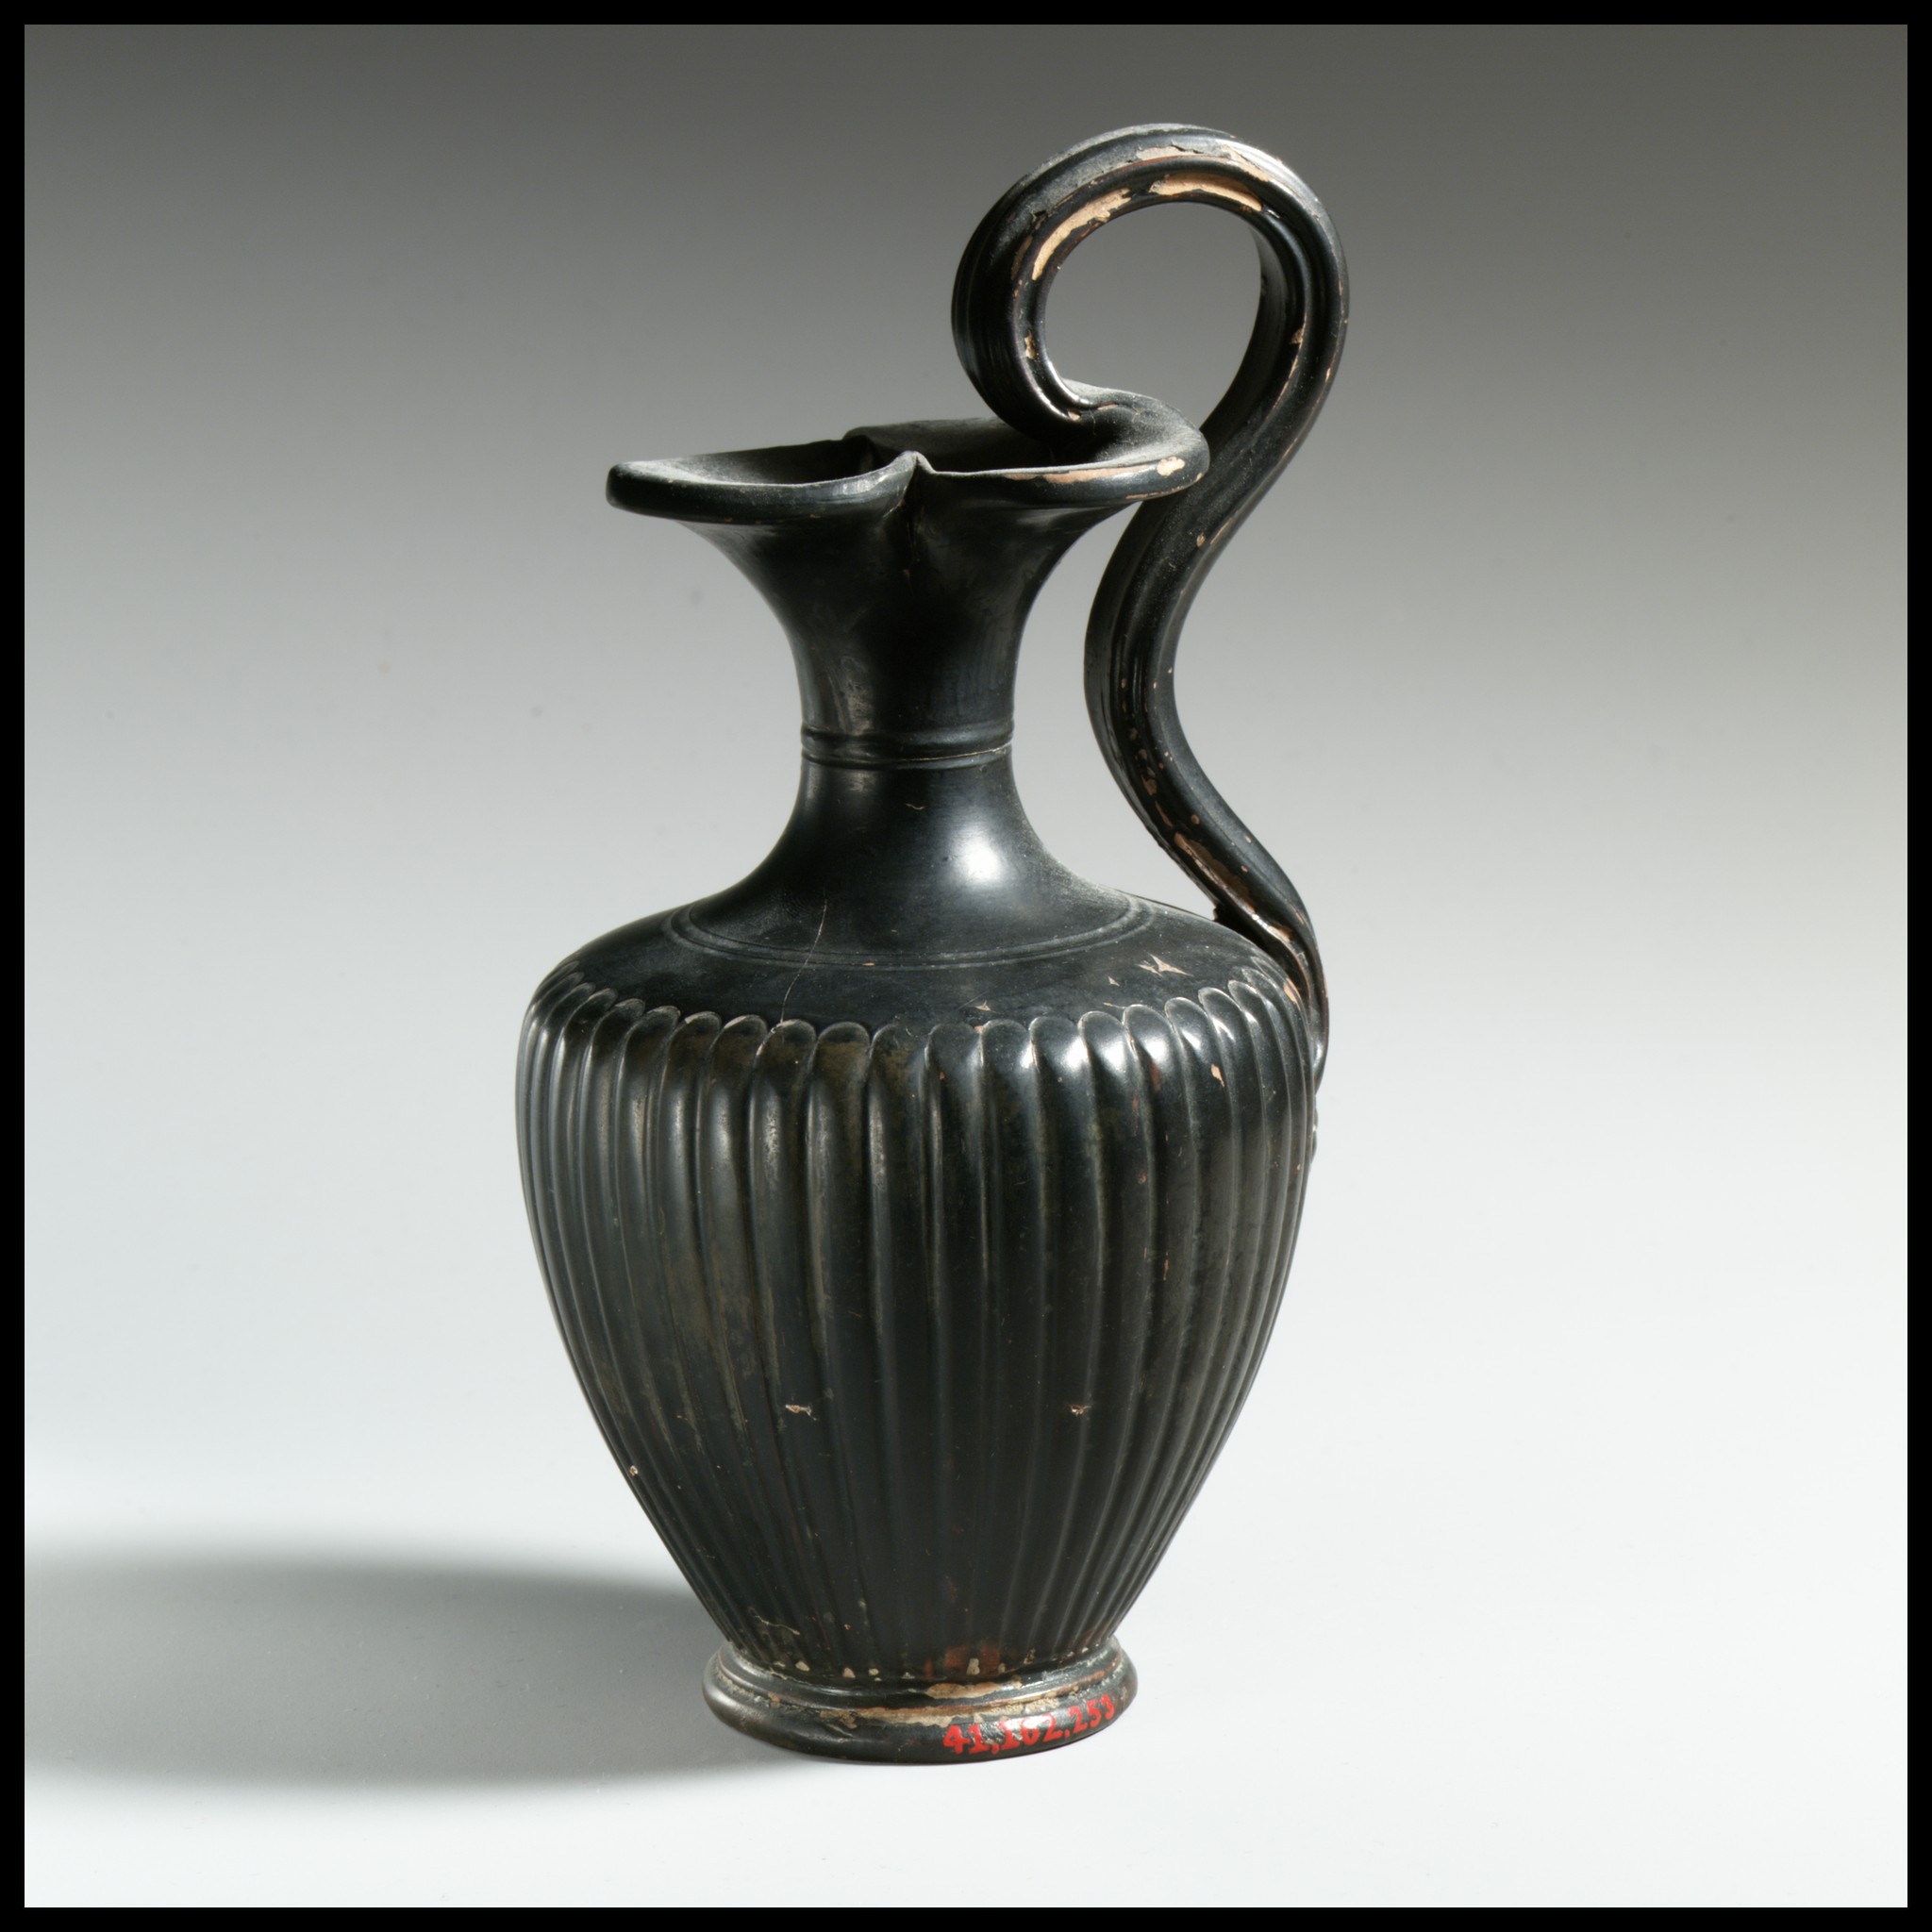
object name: oinochoe, ribbed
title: Terracotta oinochoe (jug)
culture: etruscan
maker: group of vienna o.565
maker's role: artist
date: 400-201 BCE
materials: terracotta